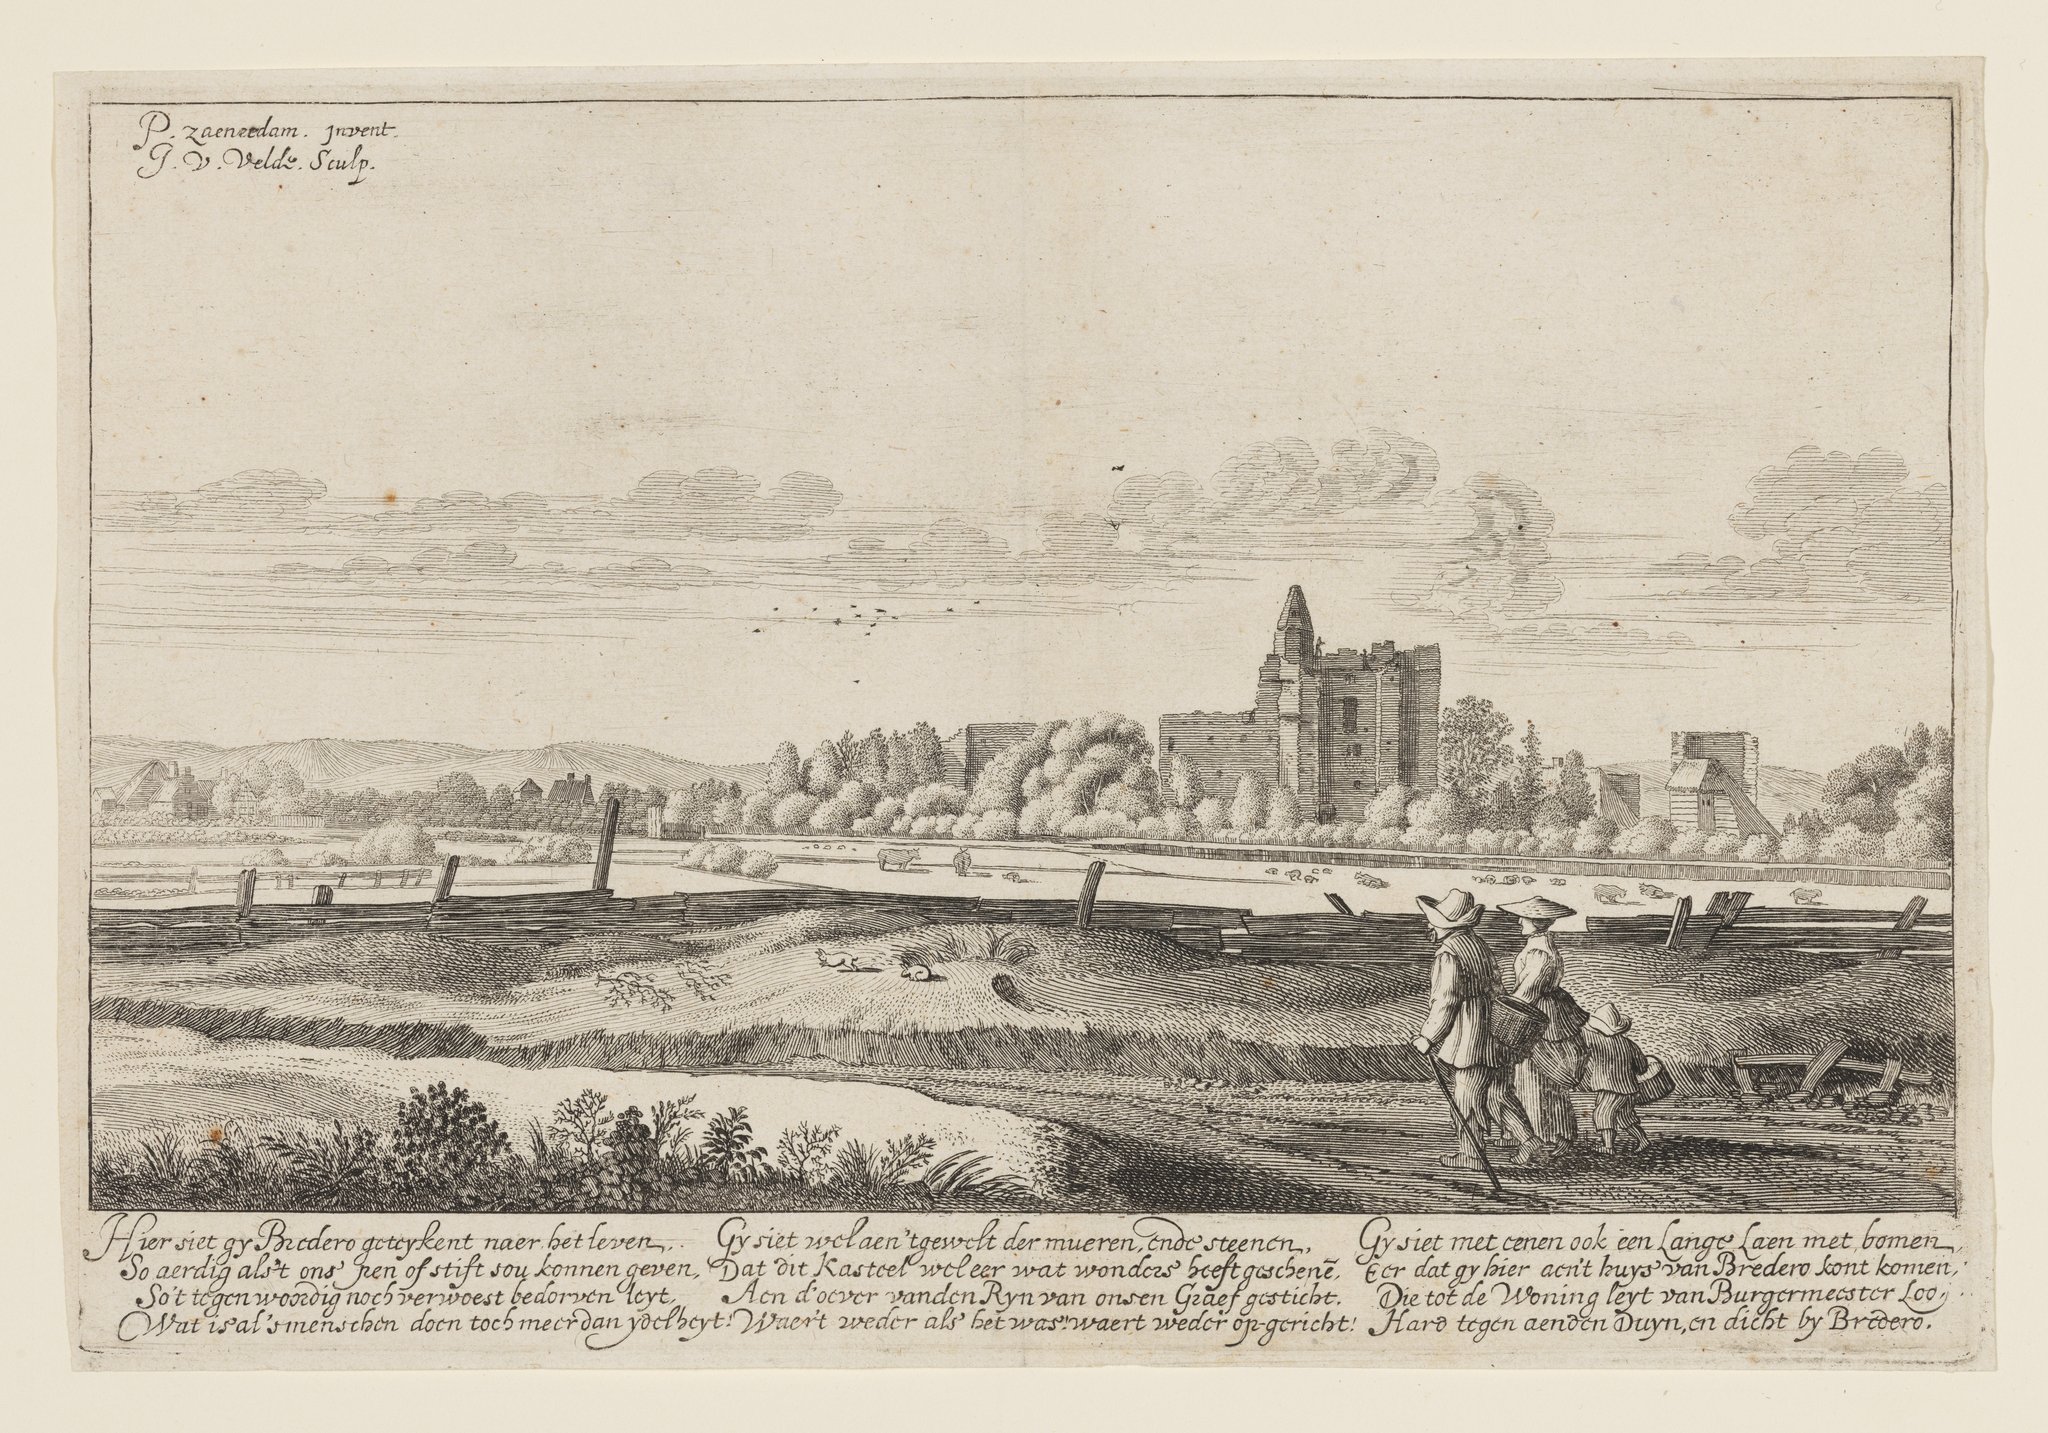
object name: print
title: Ruins of the Castle of Brederode, from "Beschryvinge ende Lof der Stad Haerlem in Holland..."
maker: jan van de velde (i)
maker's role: artist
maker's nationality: netherlandish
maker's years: 1568-1623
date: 1628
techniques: etching